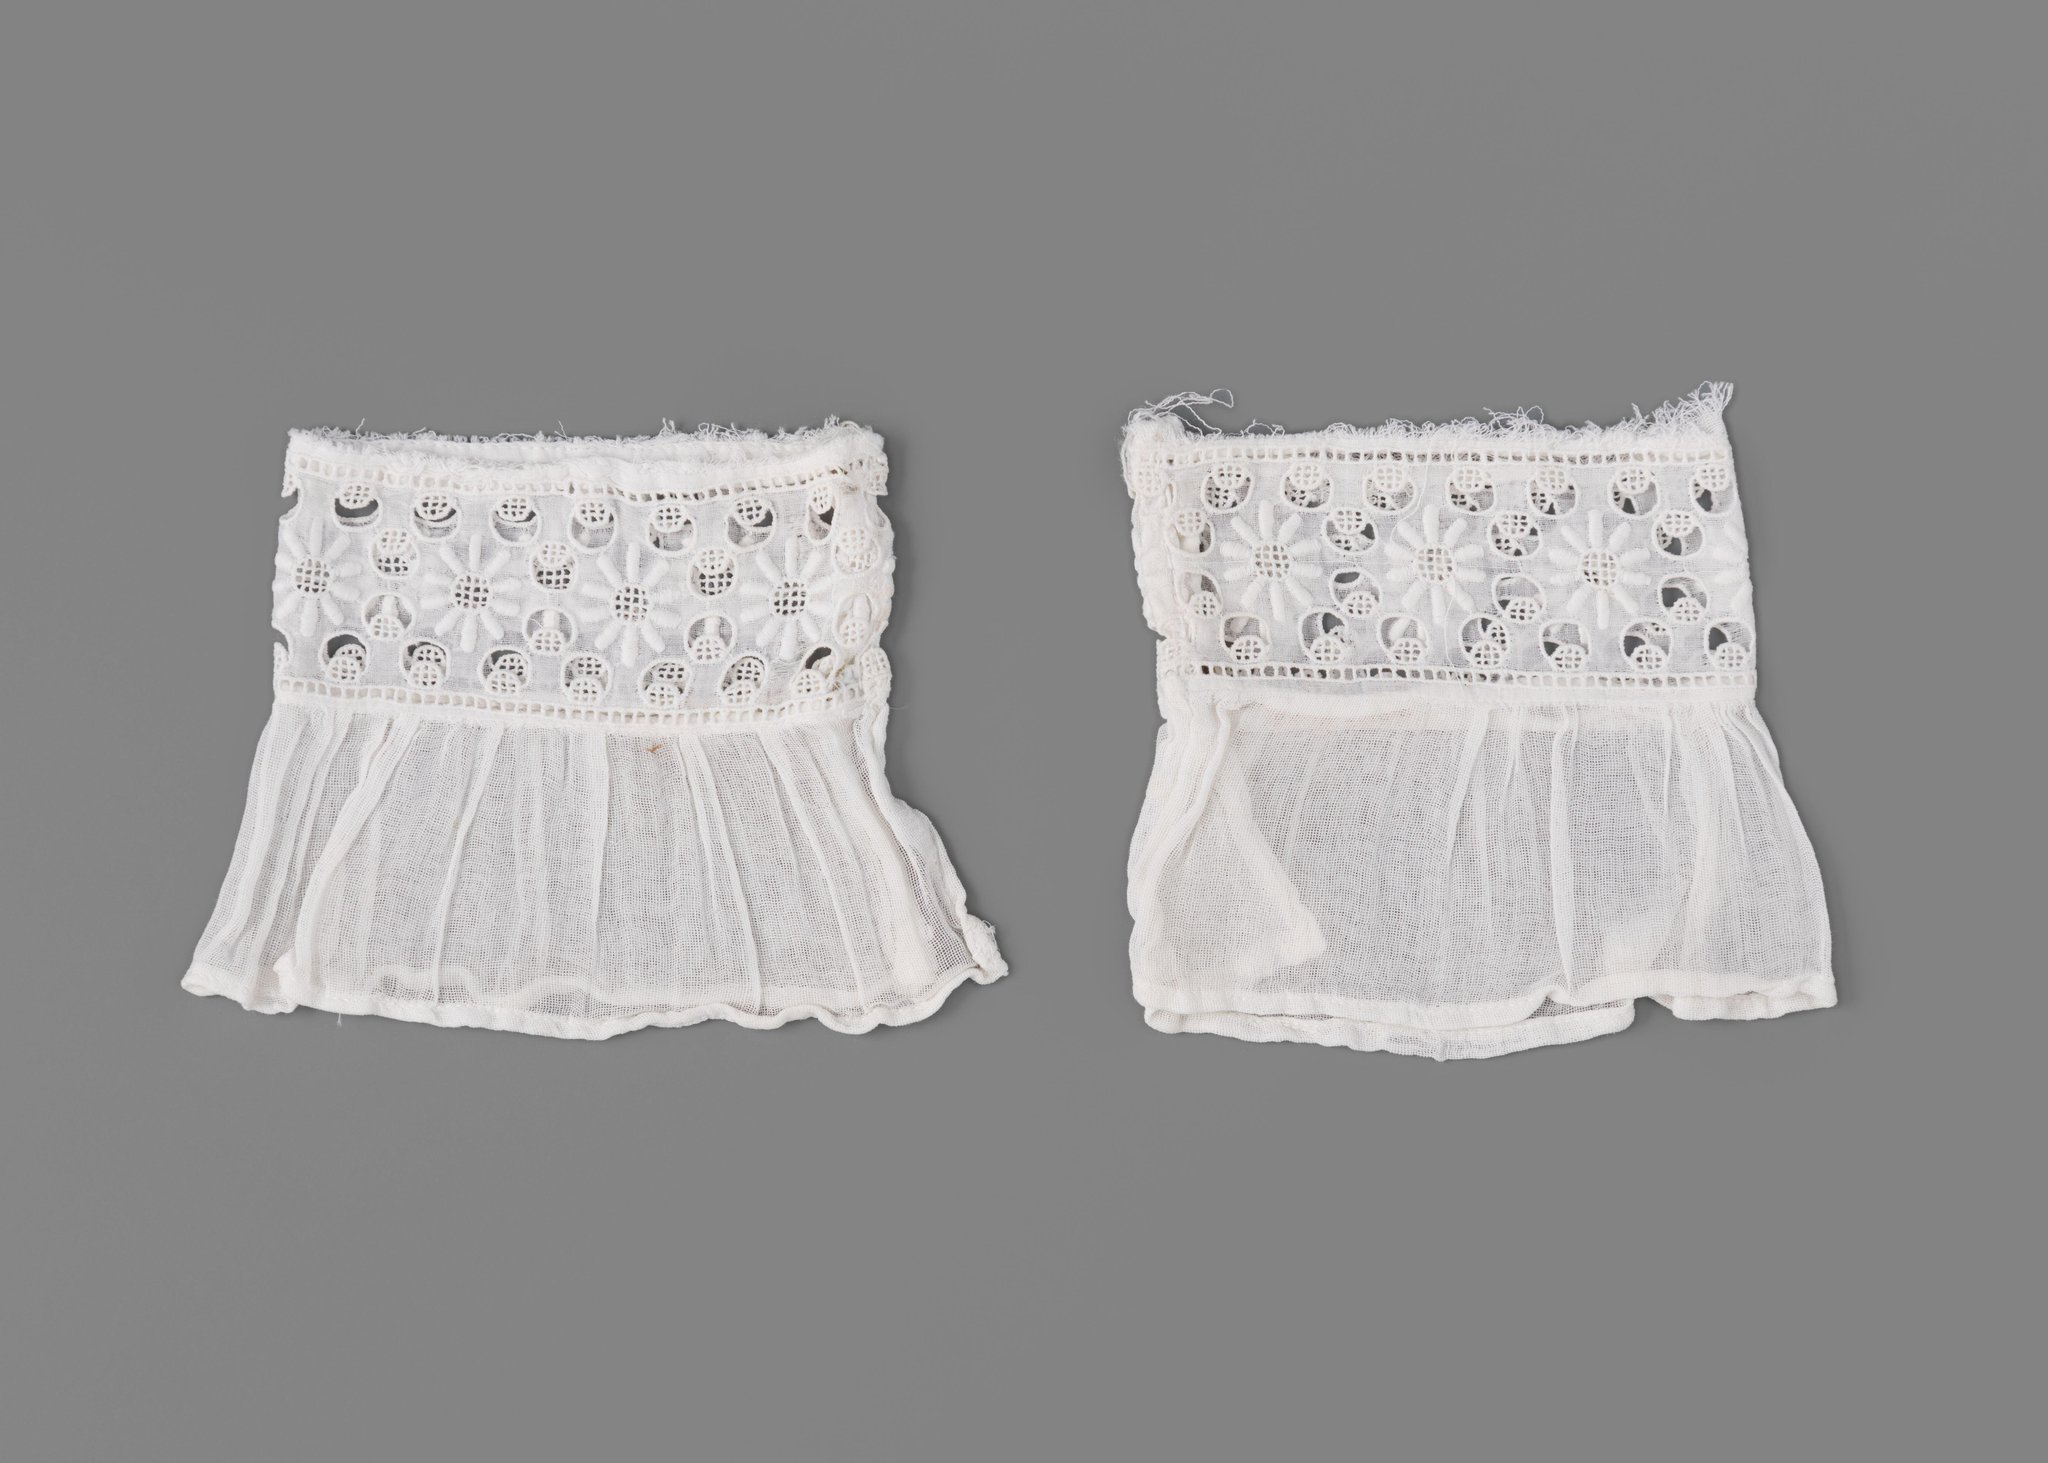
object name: cuff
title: Manchet met tussenzetsel met geabstraheerd bloemmotief geplaatst tussen acht opengewerkte cirkels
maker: Anonymous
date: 1850-1920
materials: linen, metal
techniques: embroidery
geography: western europe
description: Manchet met tussenzetsel met geabstraheerd bloemmotief geplaatst tussen acht opengewerkte cirkels.